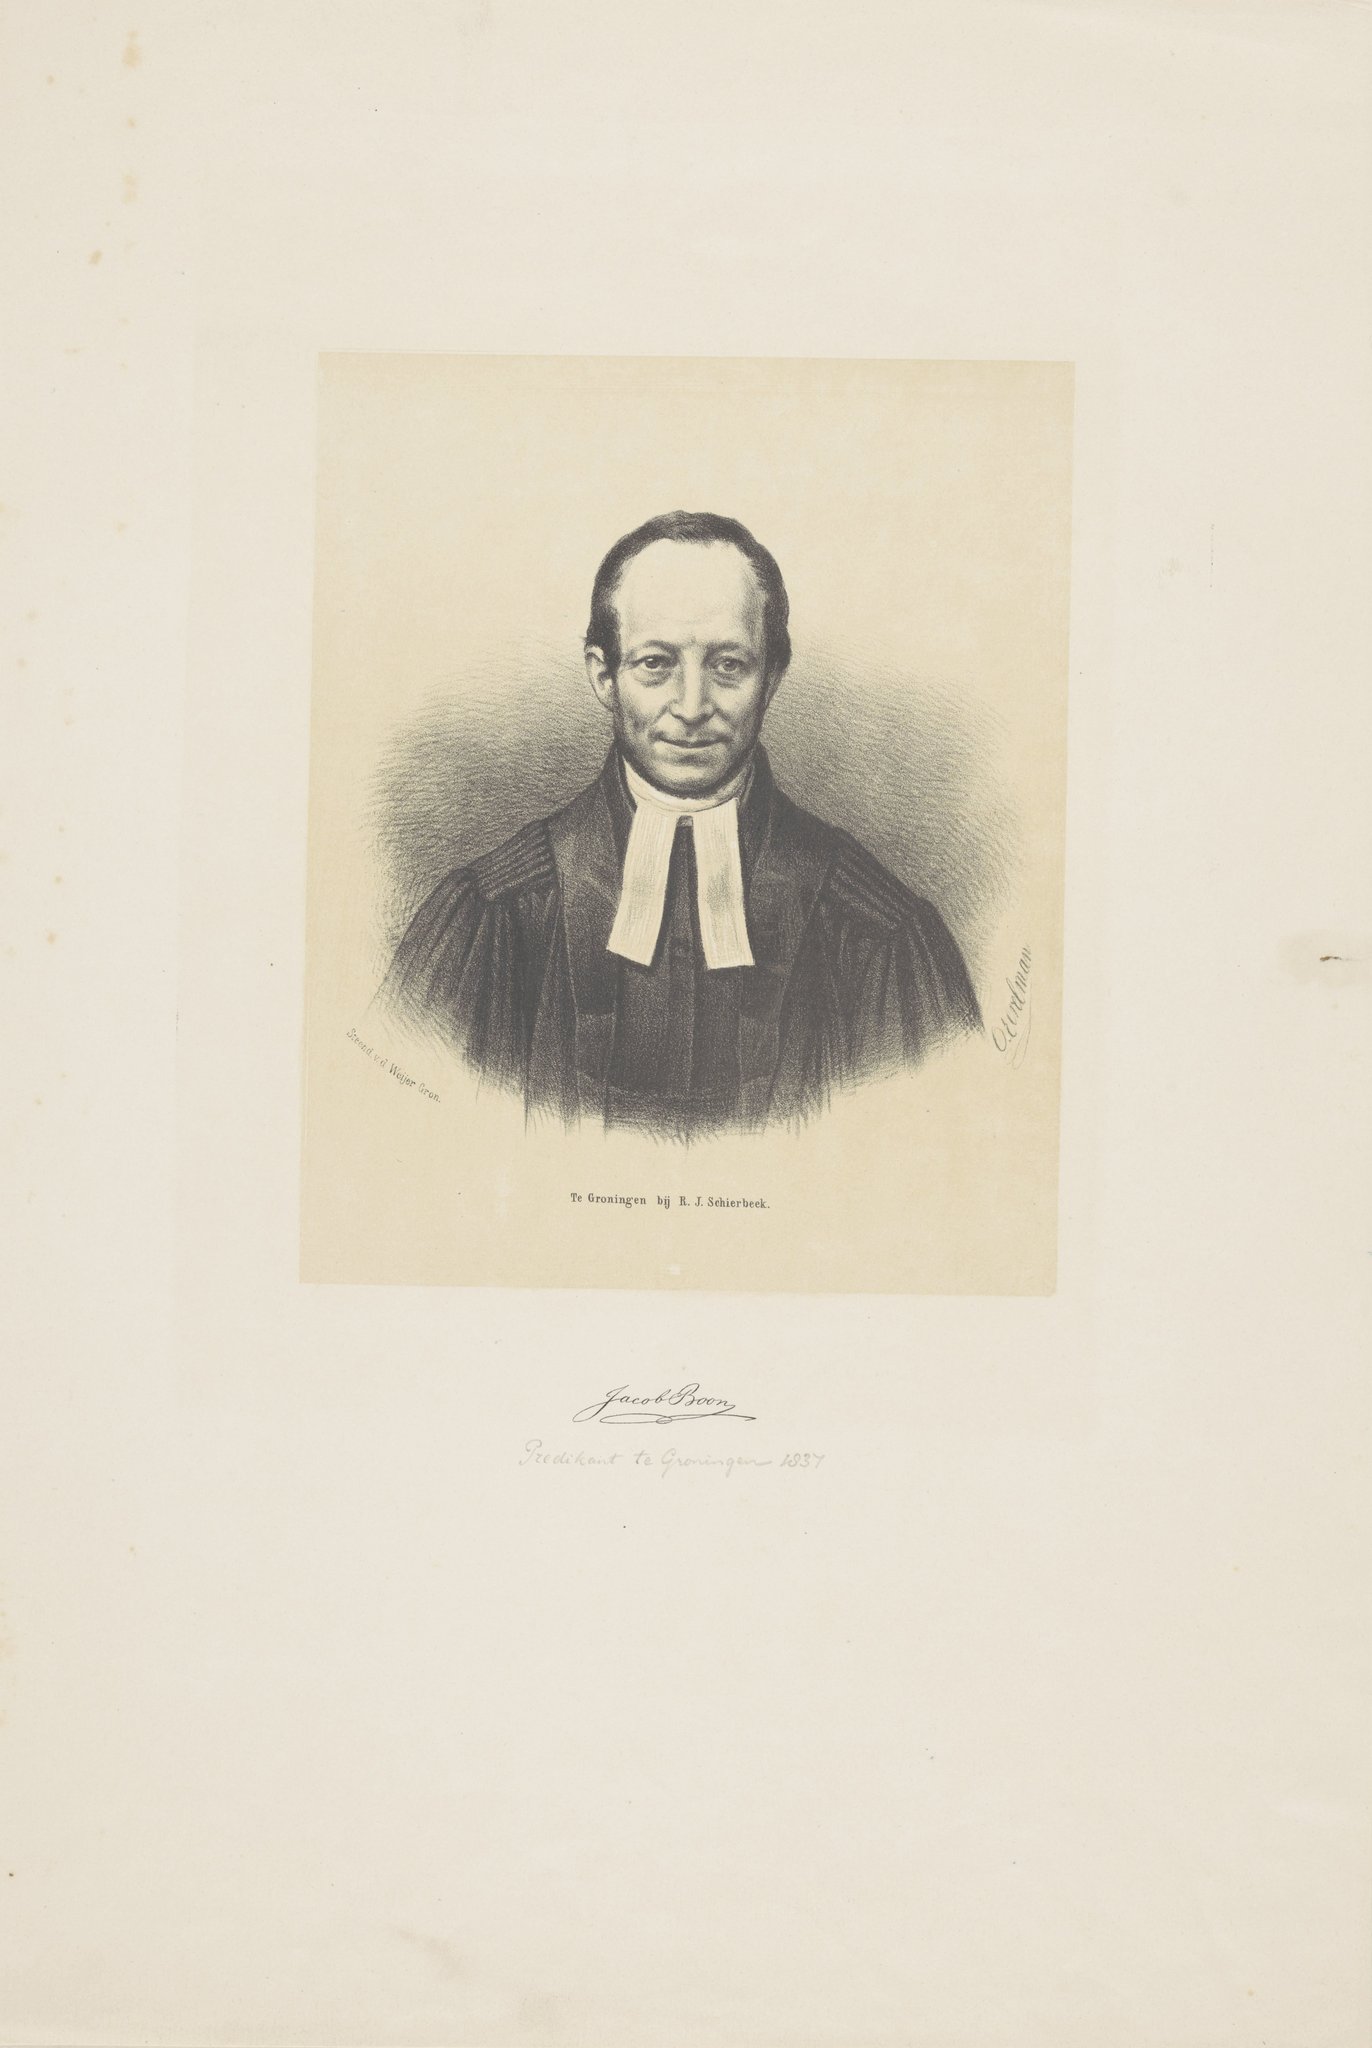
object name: print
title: Portret van Jacob Boon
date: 1849-1907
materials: paper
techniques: tone lithography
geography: groningen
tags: delft, historical persons (+ (full) bust portrait)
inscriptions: collector's mark: Lugt 2228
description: De geportretteerde is frontaal afgebeeld en draagt een toga en dubbele bef. Onder het portret zijn signatuur.